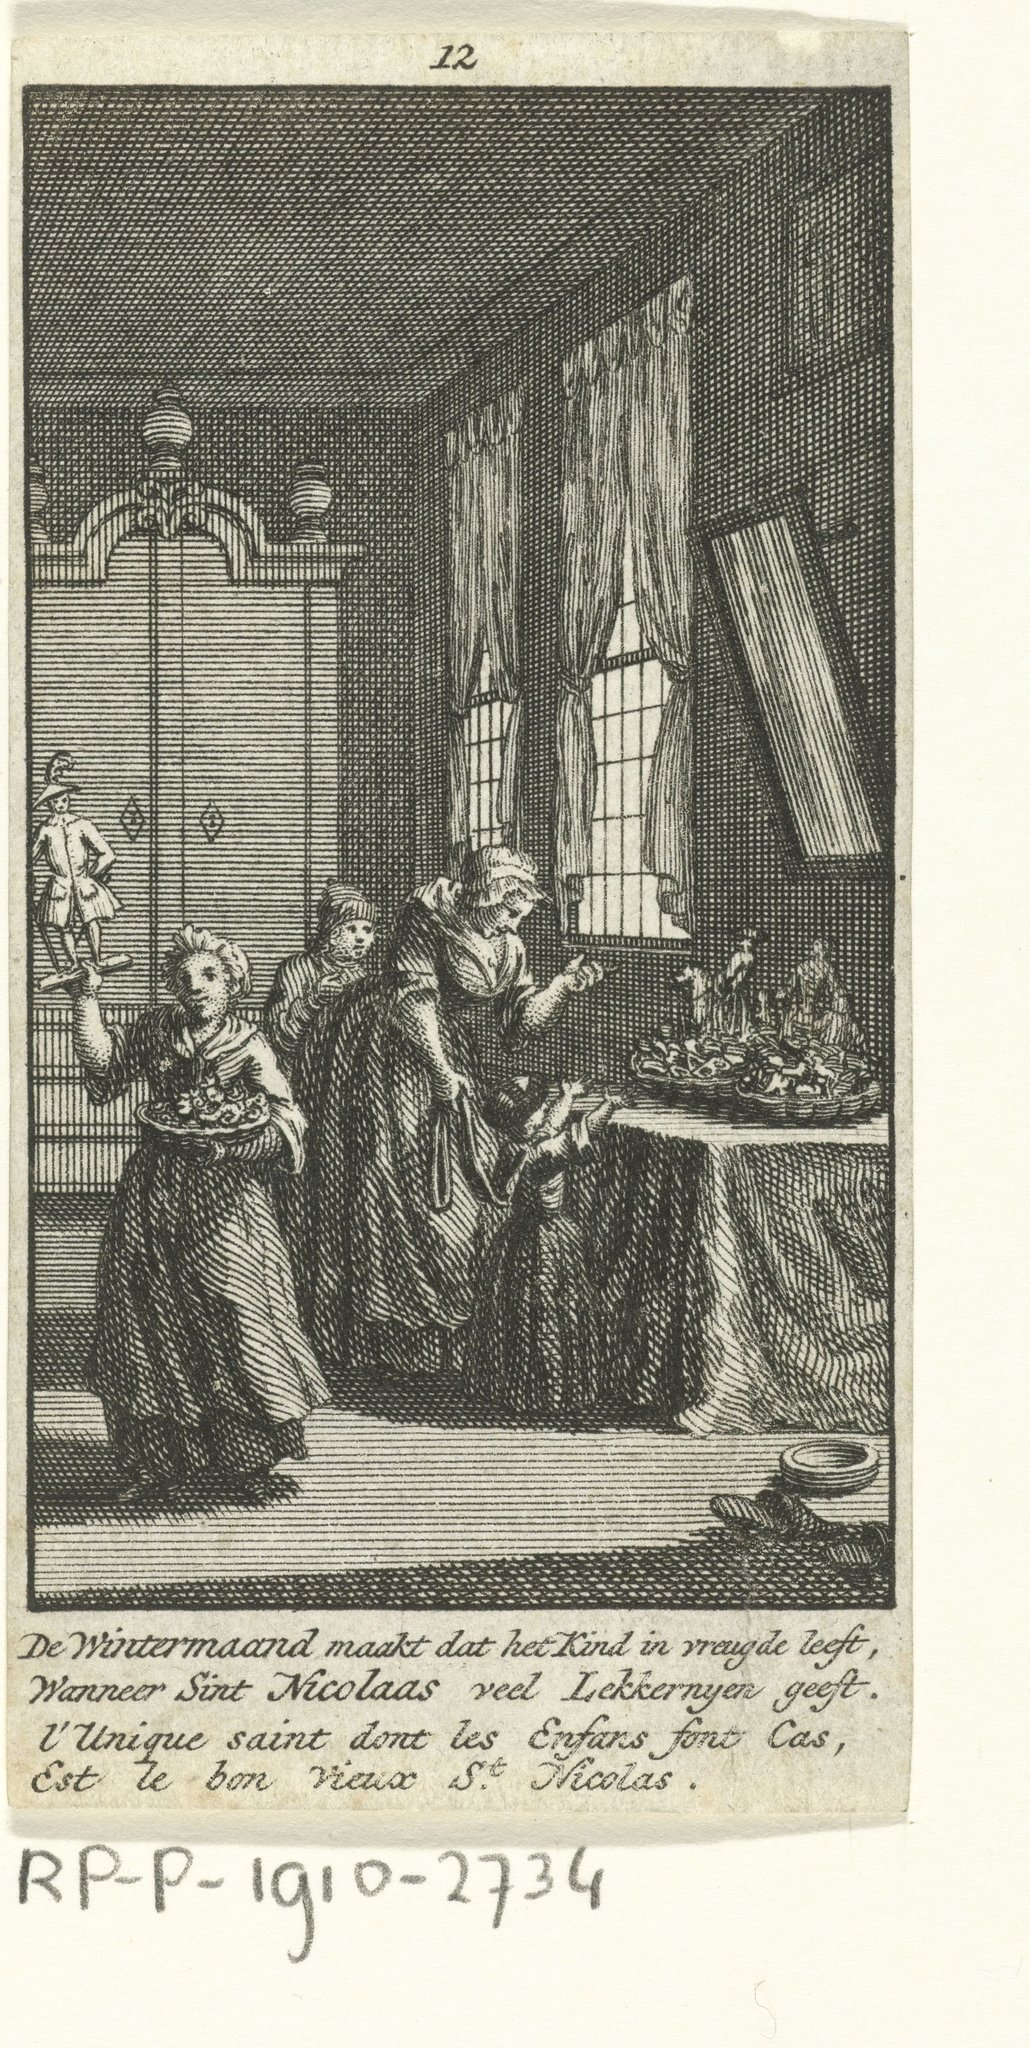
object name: print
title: De twaalf maanden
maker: jan caspar philips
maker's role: draughtsman, print maker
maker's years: 1700-1775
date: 1736-1775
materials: paper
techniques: engraving, etching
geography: amsterdam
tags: december and its 'labours', festivities on st. nicholas (eve) (december 5)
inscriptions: collector's mark: Lugt 2228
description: De maand december: interieur met een familie die het Sinterklaasfeest viert. In de marge een tweeregelig gedicht in het Nederlands en in het Frans.